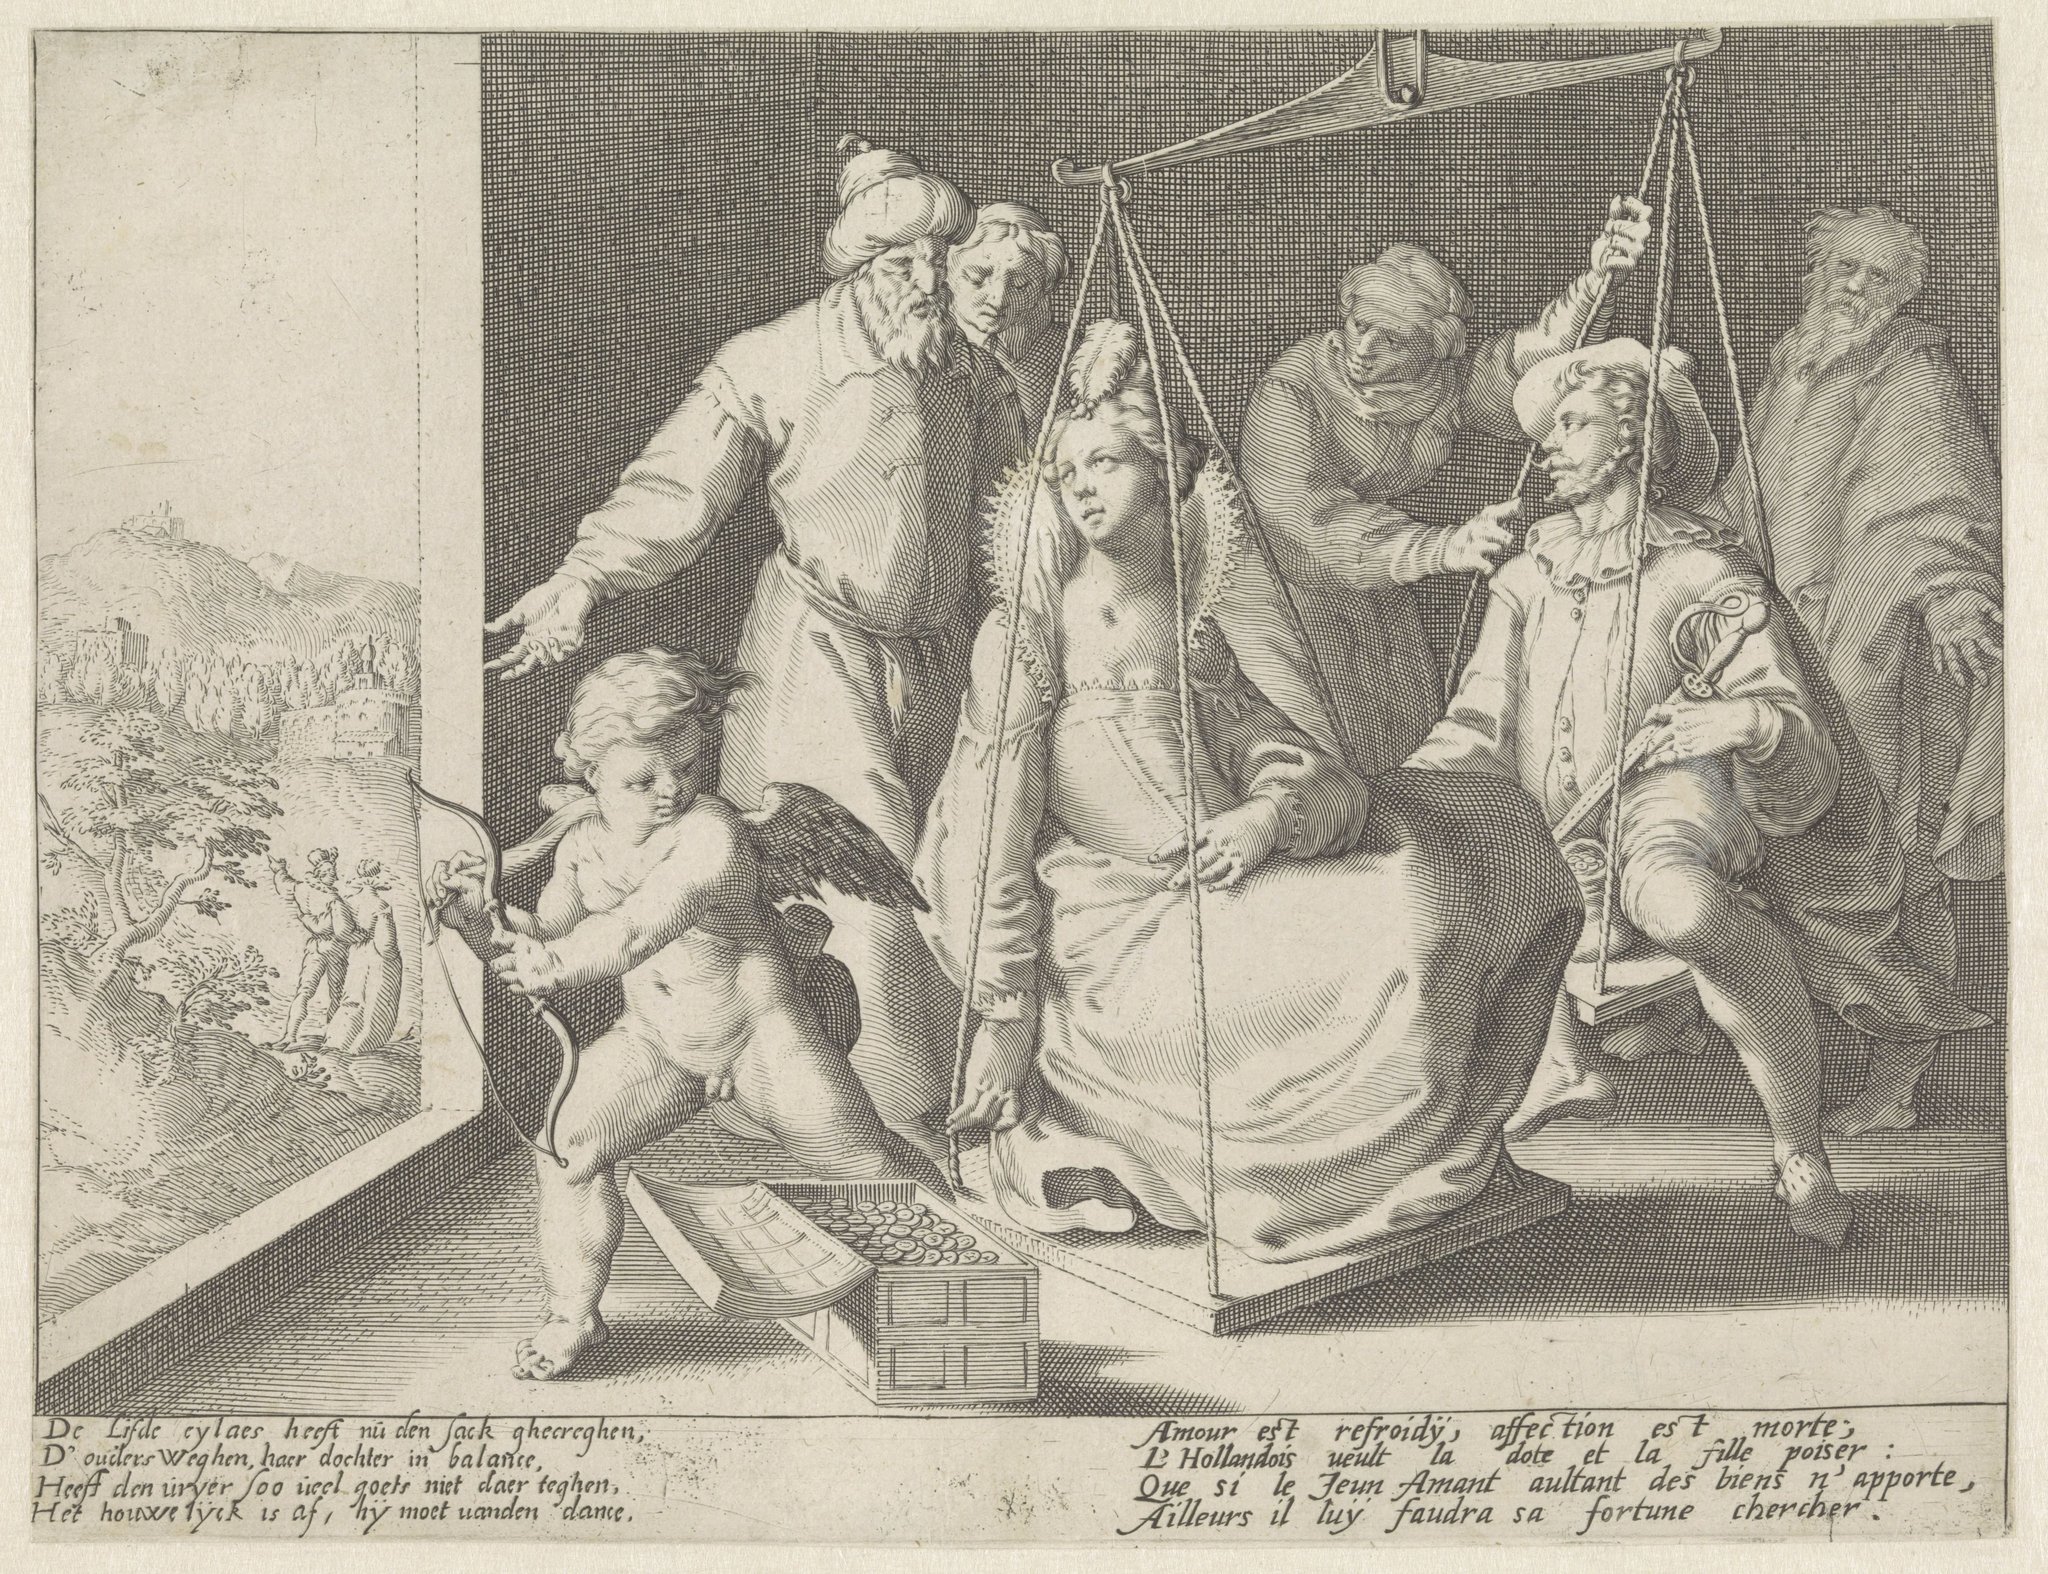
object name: print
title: De huwelijksweegschaal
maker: pieter de jode (i)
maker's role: draughtsman, print maker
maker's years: 1570-1634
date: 1590-1595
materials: paper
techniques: engraving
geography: antwerp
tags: scales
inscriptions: collector's mark: Lugt 2760, collector's mark: Lugt 2228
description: Een rijke jonge vrouw en een armere jongeman worden gewogen op een weegschaal door hun ouders. De kant van de weegschaal waar de jongeman zit wordt naar beneden getrokken door zijn moeder, maar de kant van de bruid blijft zwaarder. De man is niet rijk genoeg voor de bruid. Cupido, gewapend met een boog, werpt een blik op de volle geldkist en neemt de benen. Met onderschrift van twee vierregelige verzen in het Nederlands en Frans.